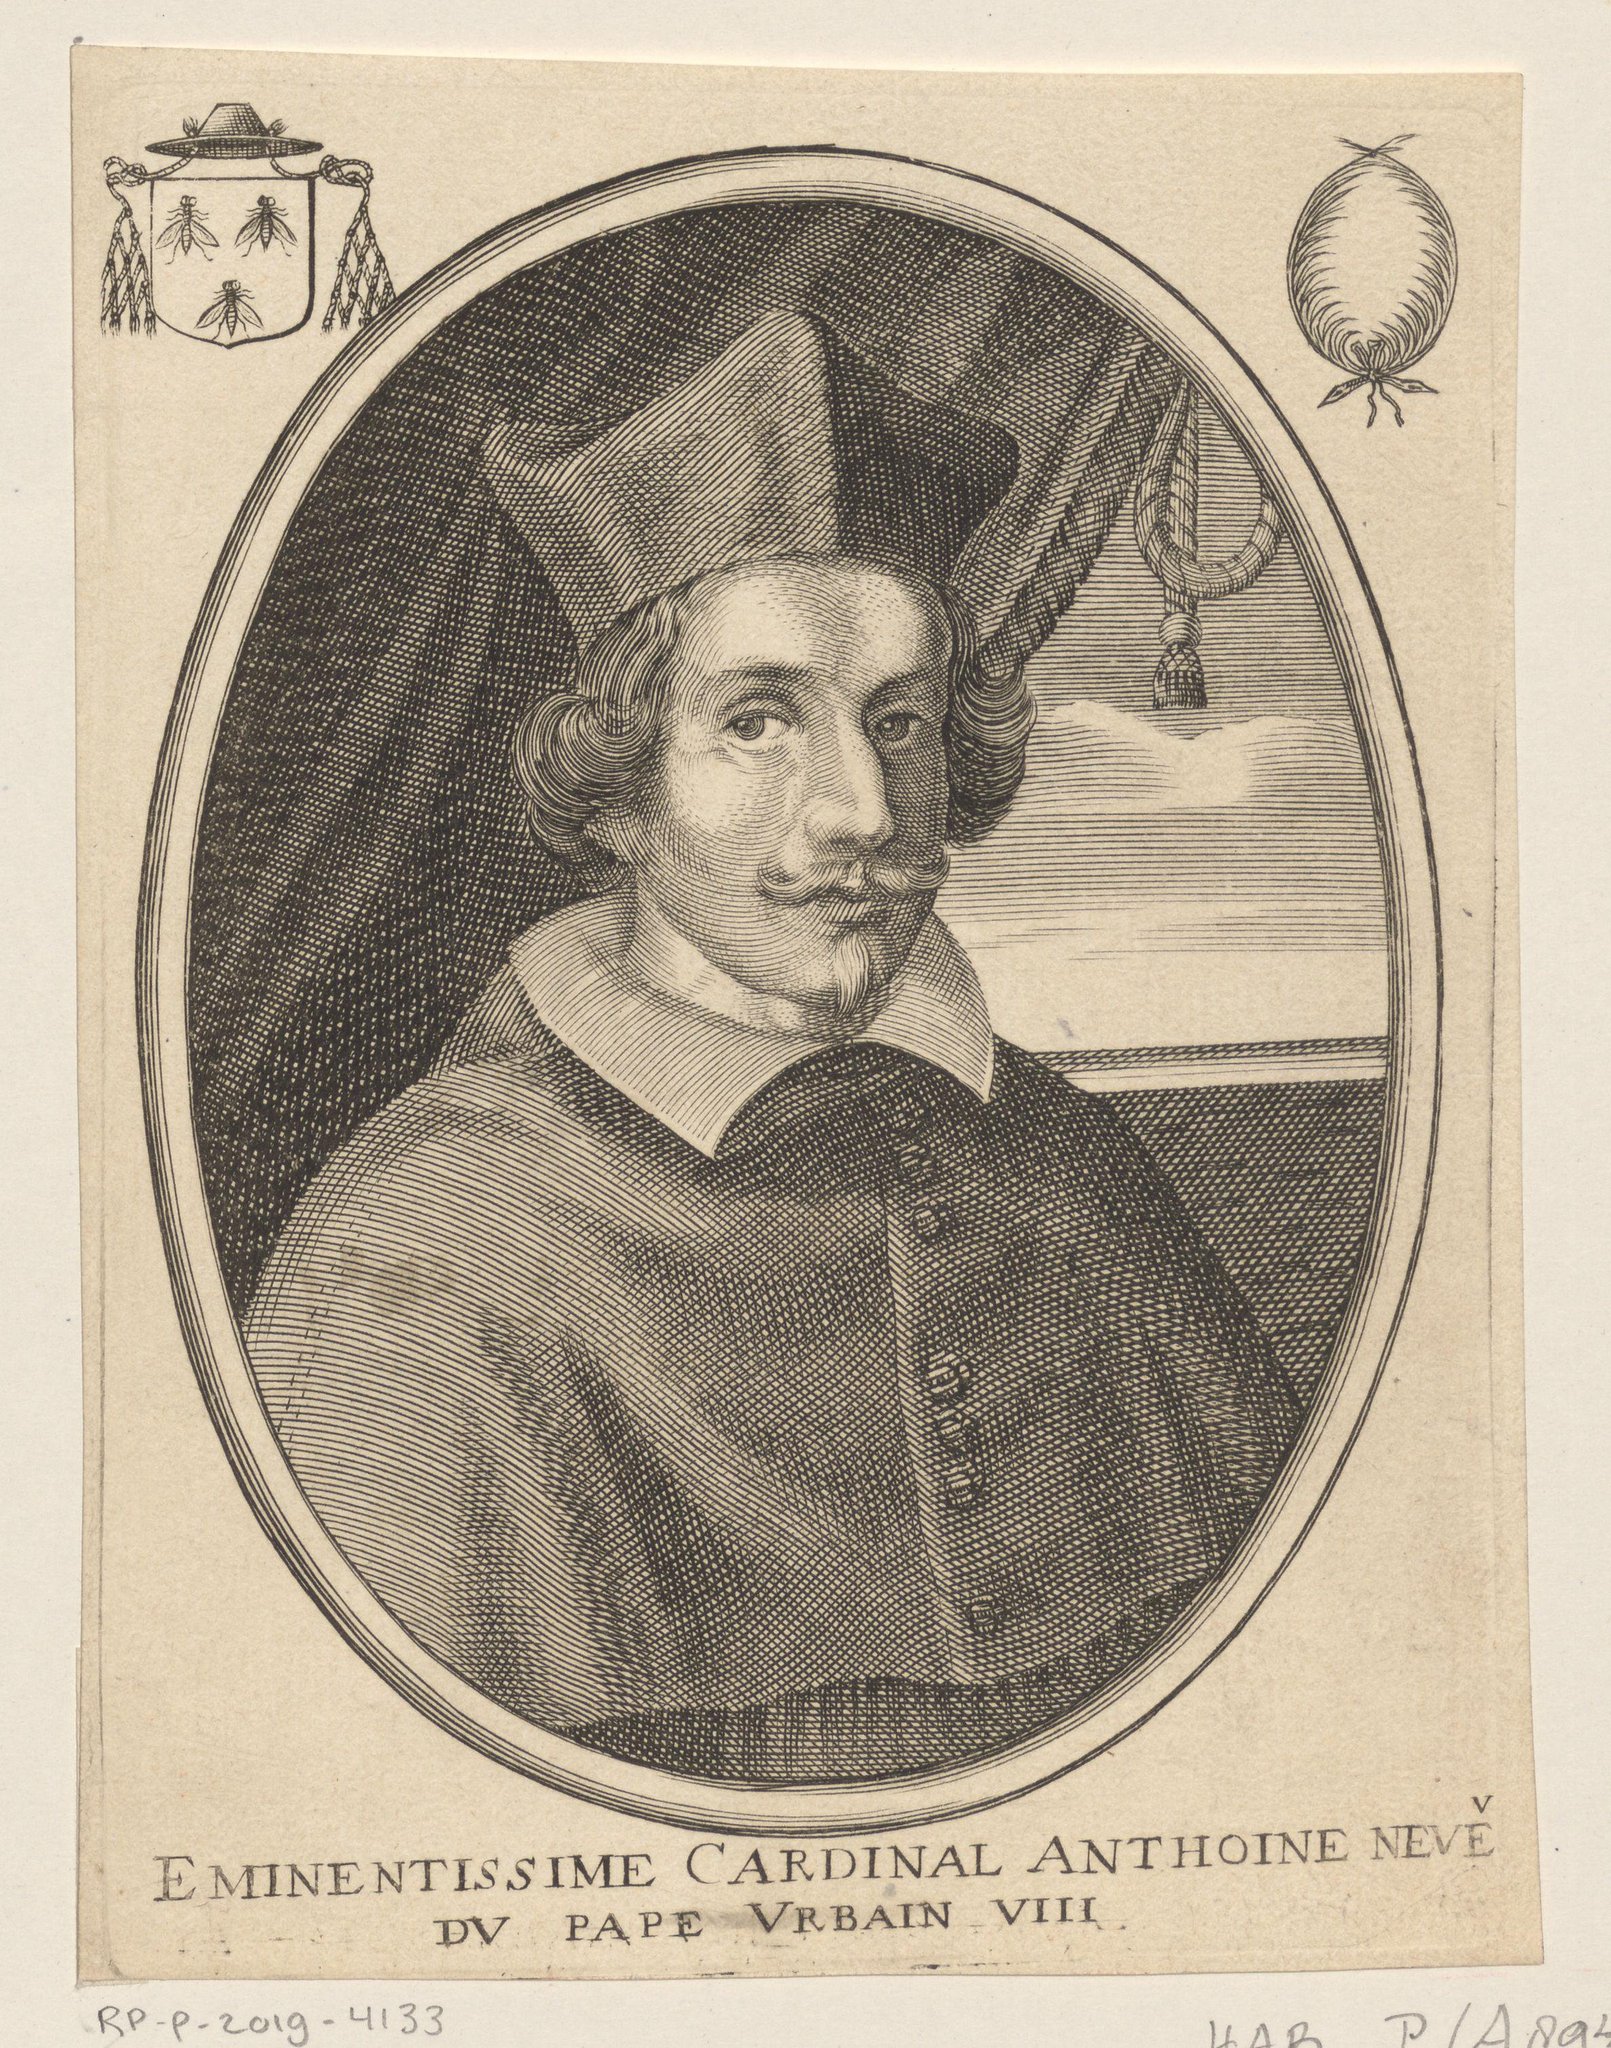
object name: print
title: Portret van kardinaal Antonio Barberini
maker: balthazar moncornet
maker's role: print maker, publisher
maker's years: 1600-1668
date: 1628-1699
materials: paper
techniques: engraving, etching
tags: rome, clergyman, antonio barberini (ii), historical persons, armorial bearing, heraldry